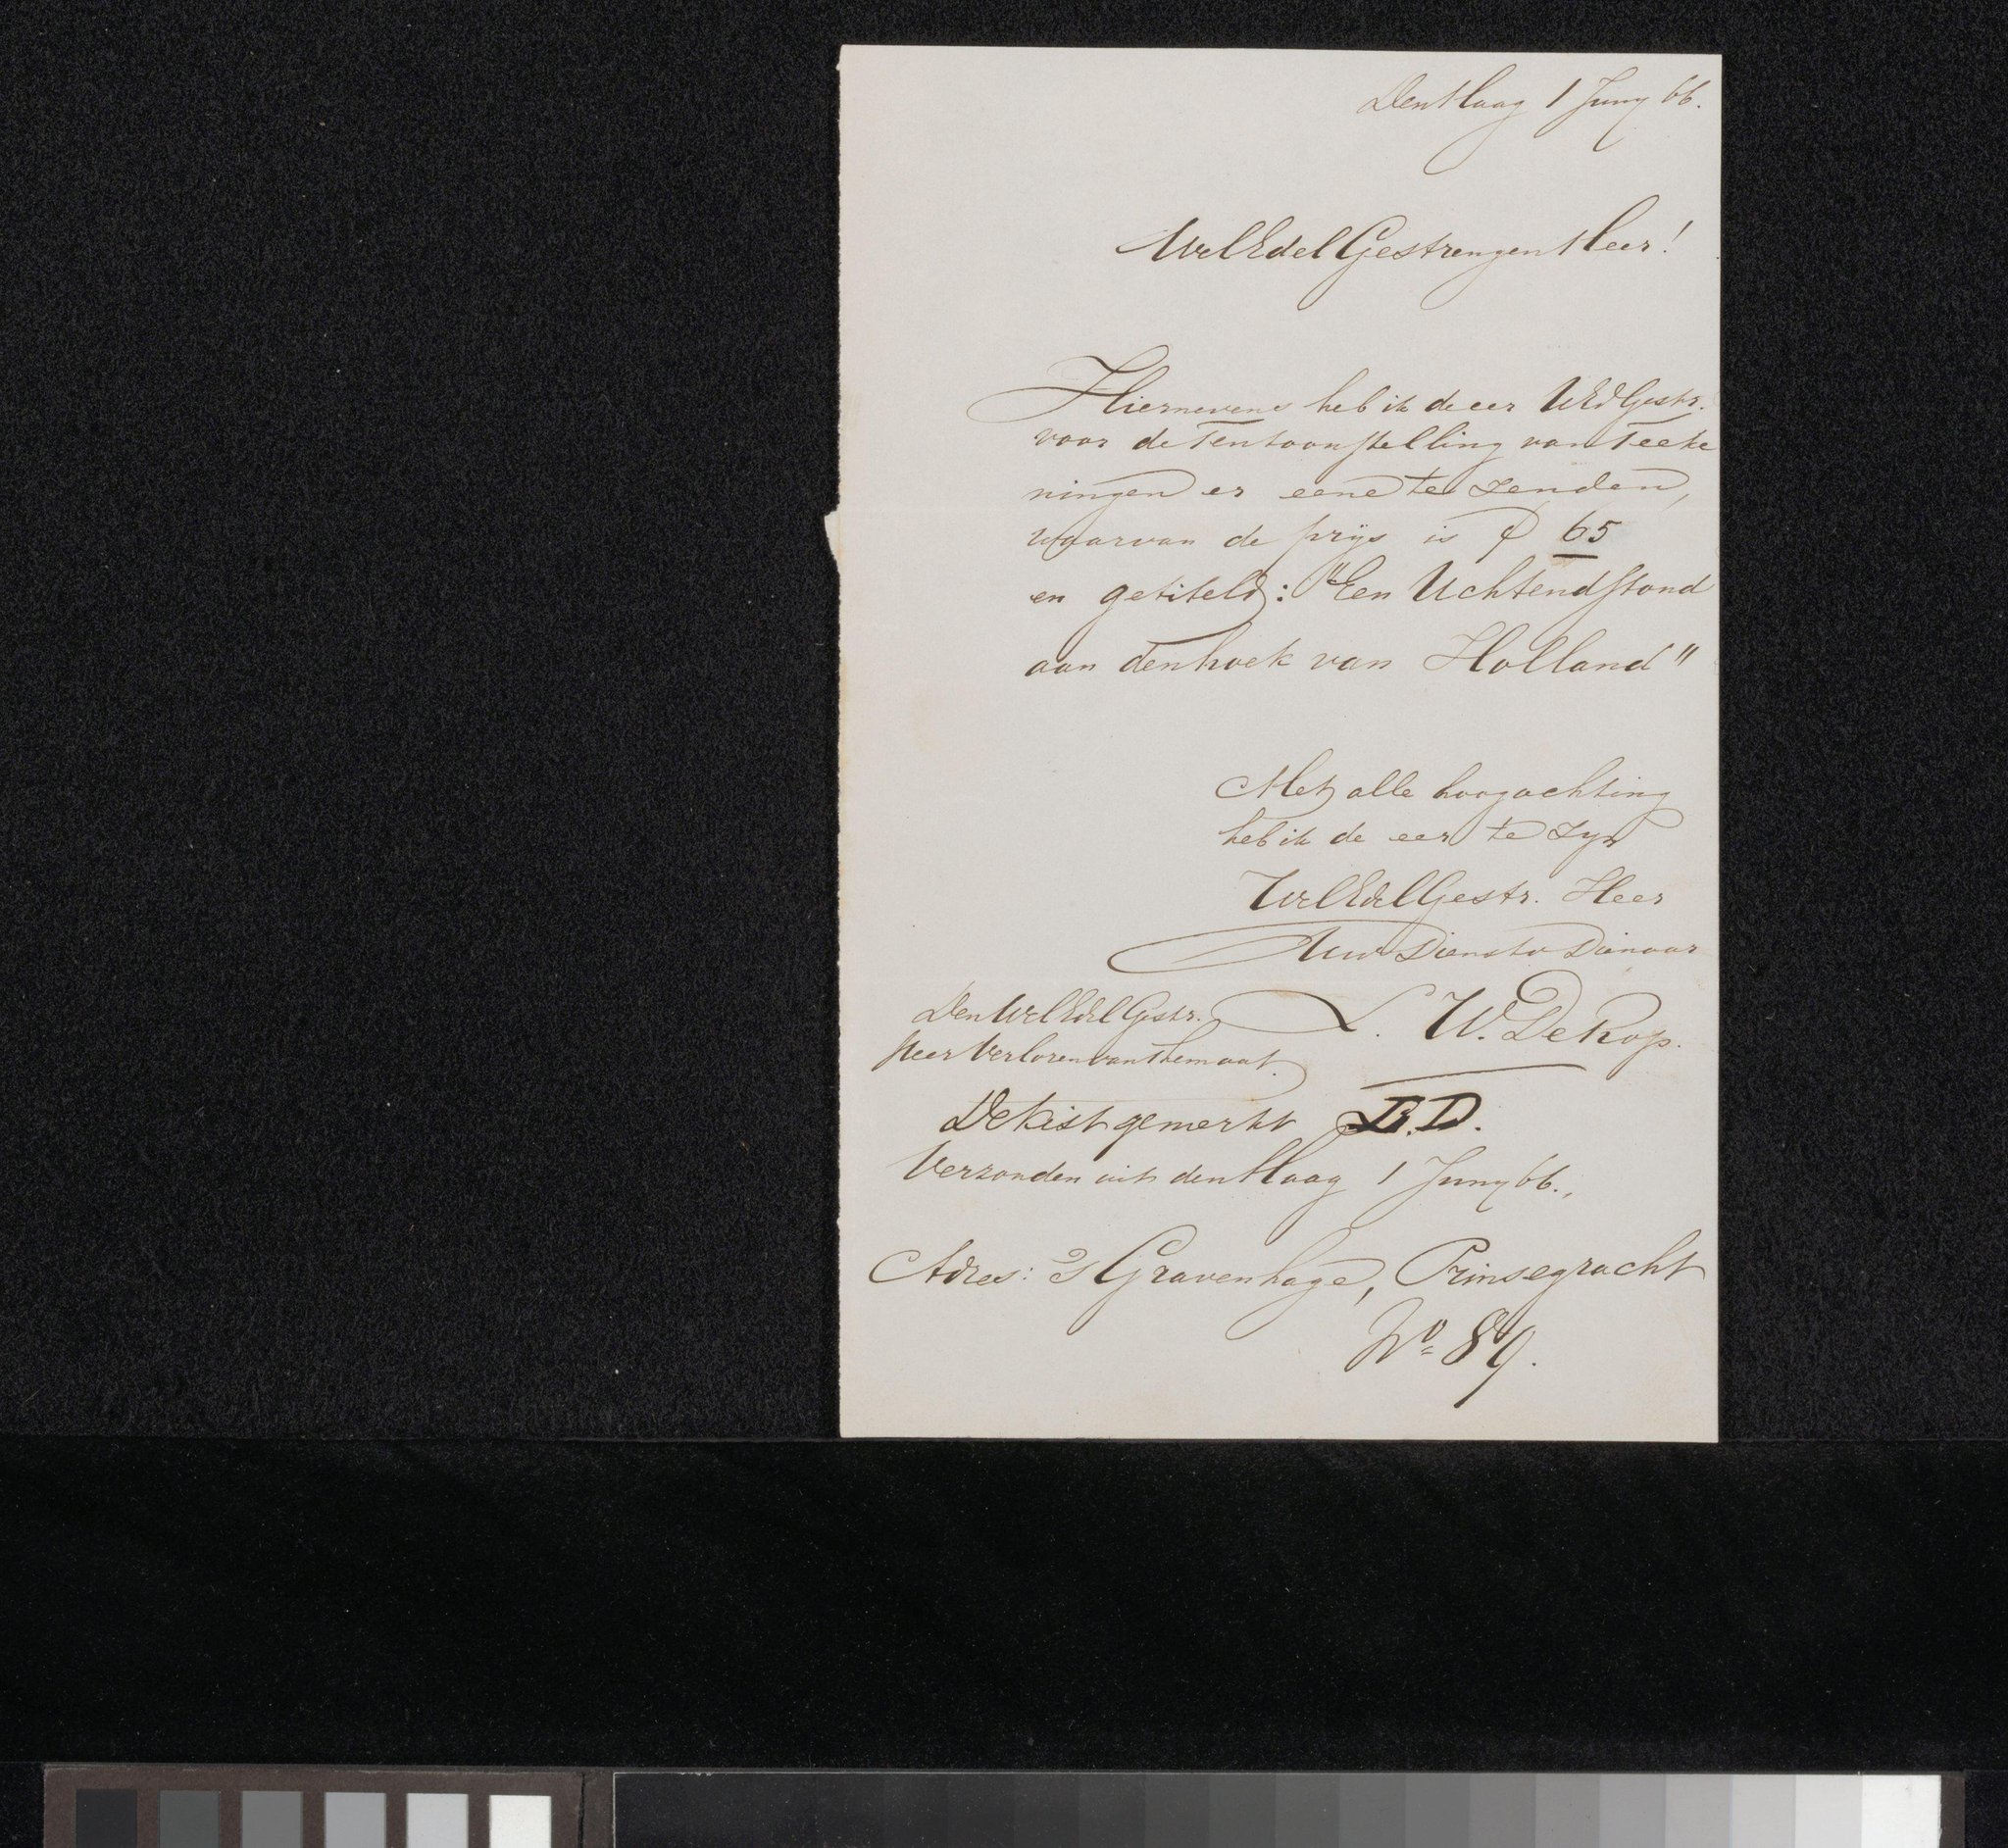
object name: letter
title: Brief aan Pieter Verloren van Themaat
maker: leonardus willebrordus derop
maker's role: painter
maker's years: 1839-1872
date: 1866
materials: ink, paper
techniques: pen, writing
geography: the hague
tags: utrecht, pieter verloren van themaat, drawing, exhibition ~ art, money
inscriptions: collector's mark: ‘RPK’